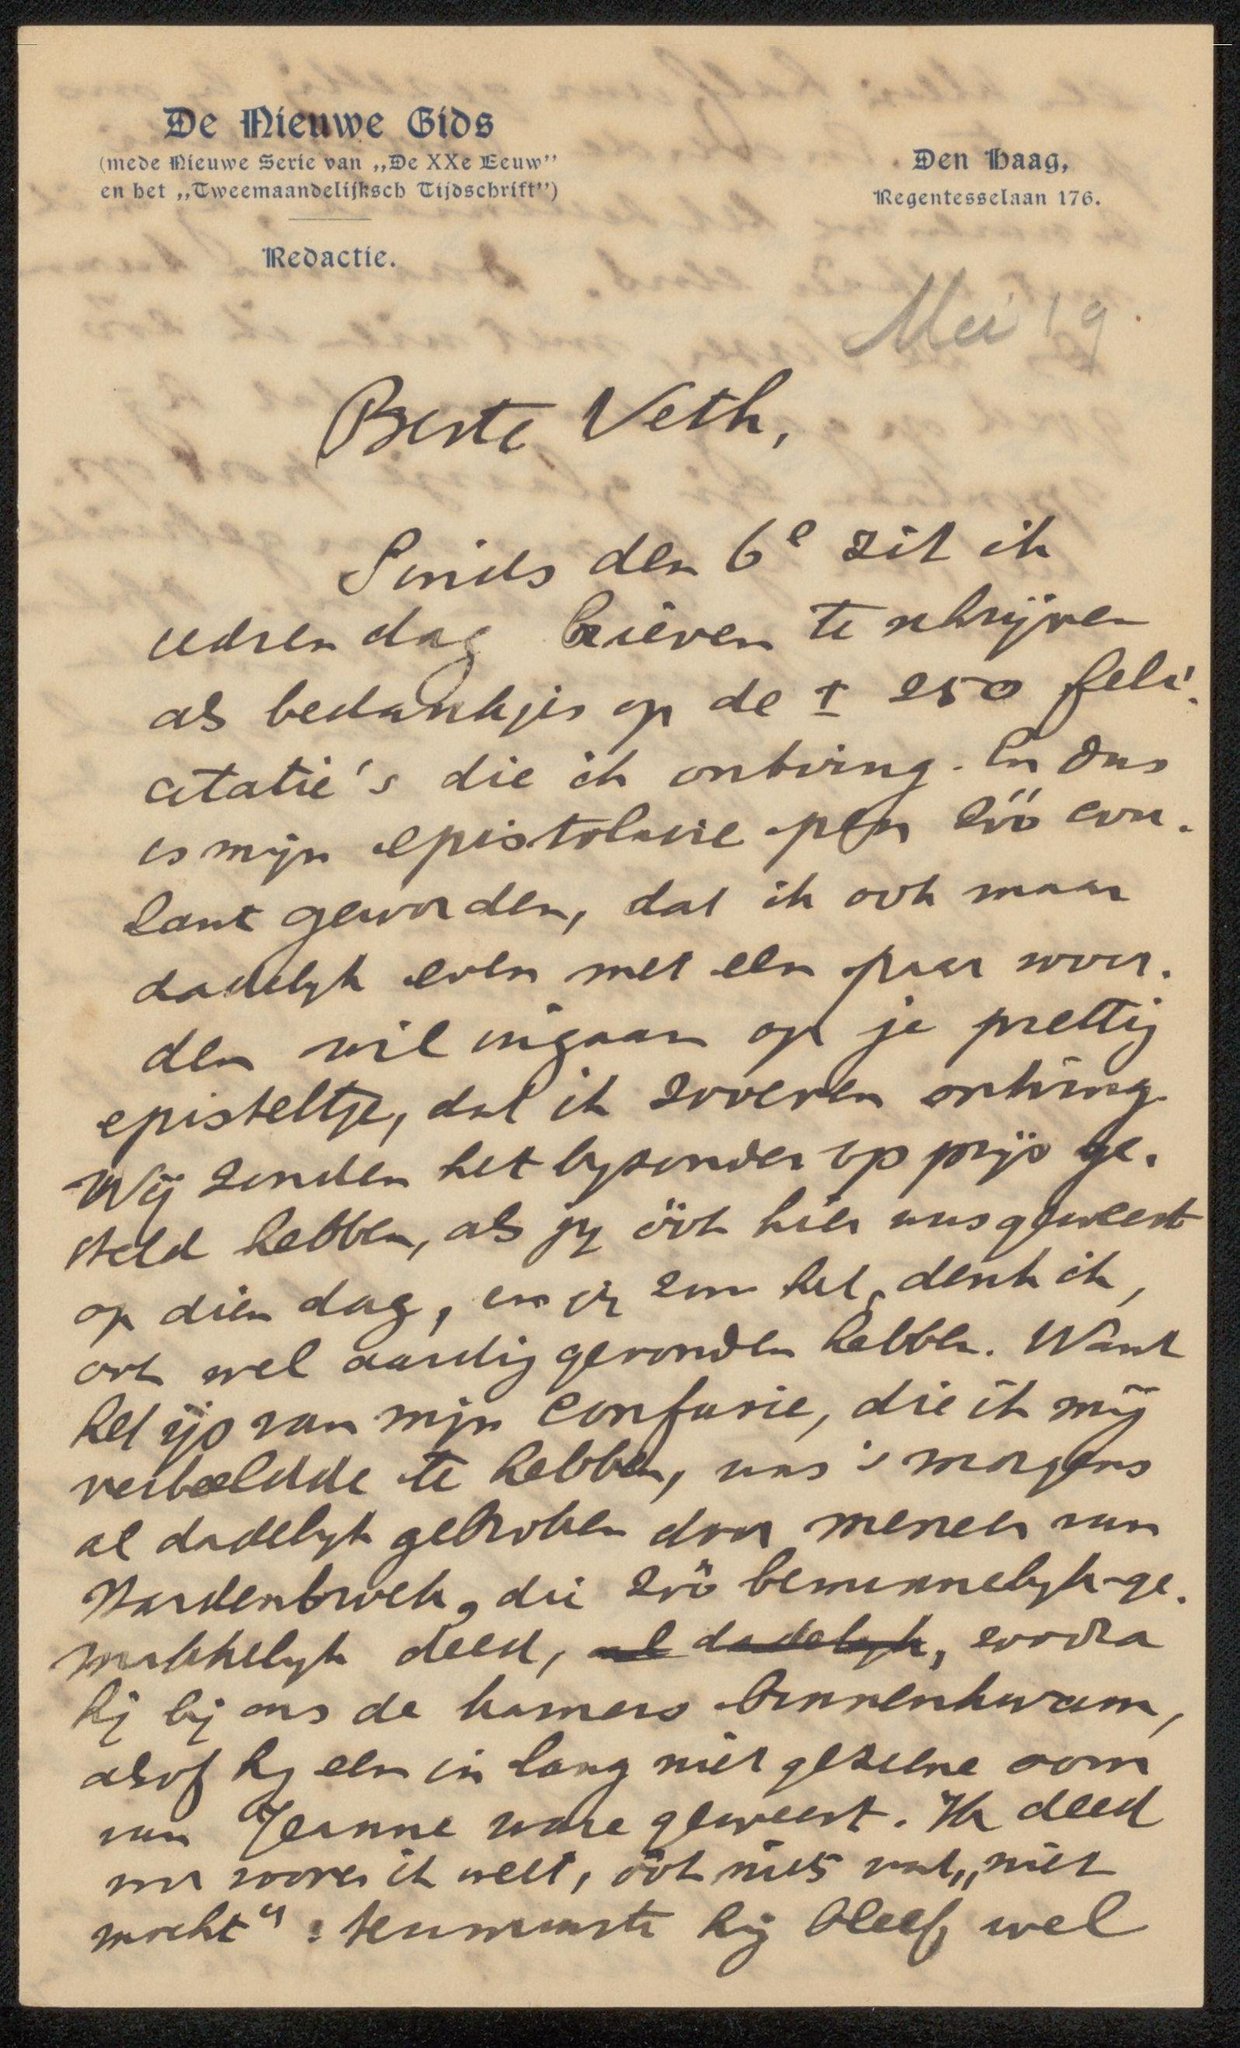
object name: letter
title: Brief aan Jan Veth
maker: willem kloos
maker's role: dichter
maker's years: 1859-1938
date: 1885-1925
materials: ink, paper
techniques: pen, printing, writing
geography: the hague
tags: dordrecht, painter, print maker, draughtsman, designer, jan veth, middelburg, pieter cornelis boutens, amsterdam, hein boeken, cyriel buysse, voorburg, maurits wagenvoort, the hague, anna maria francisca salomons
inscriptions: collector's mark: ‘RPK’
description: Brief gedateerd mei 1919 in latere hand.